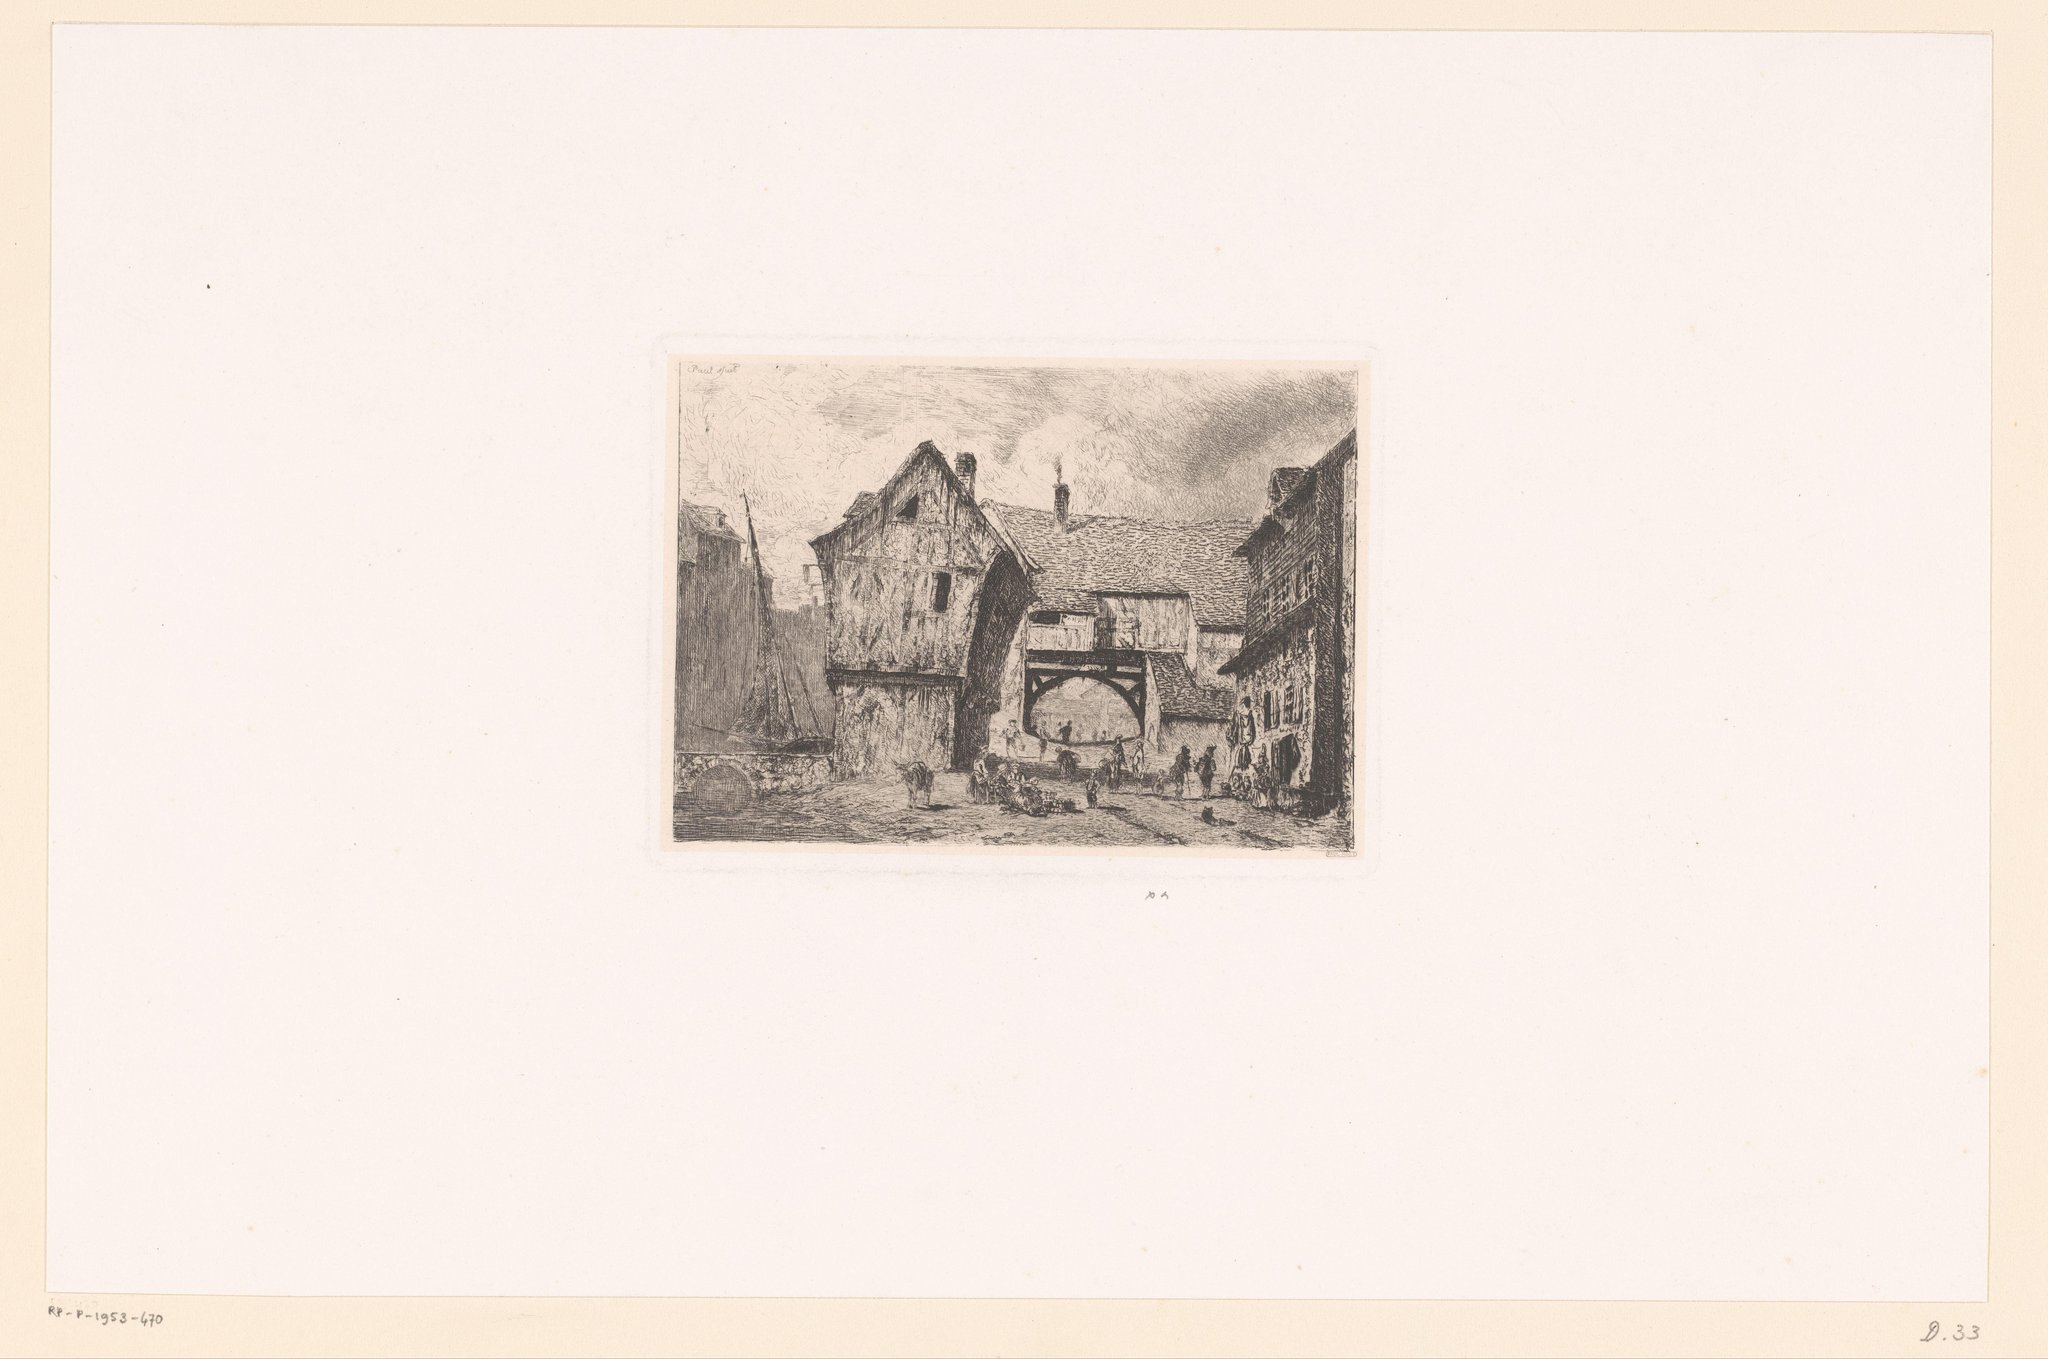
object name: print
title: Gezicht op huizen te Honfleur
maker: paul huet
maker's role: draughtsman, print maker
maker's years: 1803-1869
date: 1813-1869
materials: paper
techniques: etching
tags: civic architecture; edifices; dwellings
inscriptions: collector's mark: Lugt 2228, collector's mark: Lugt 2760